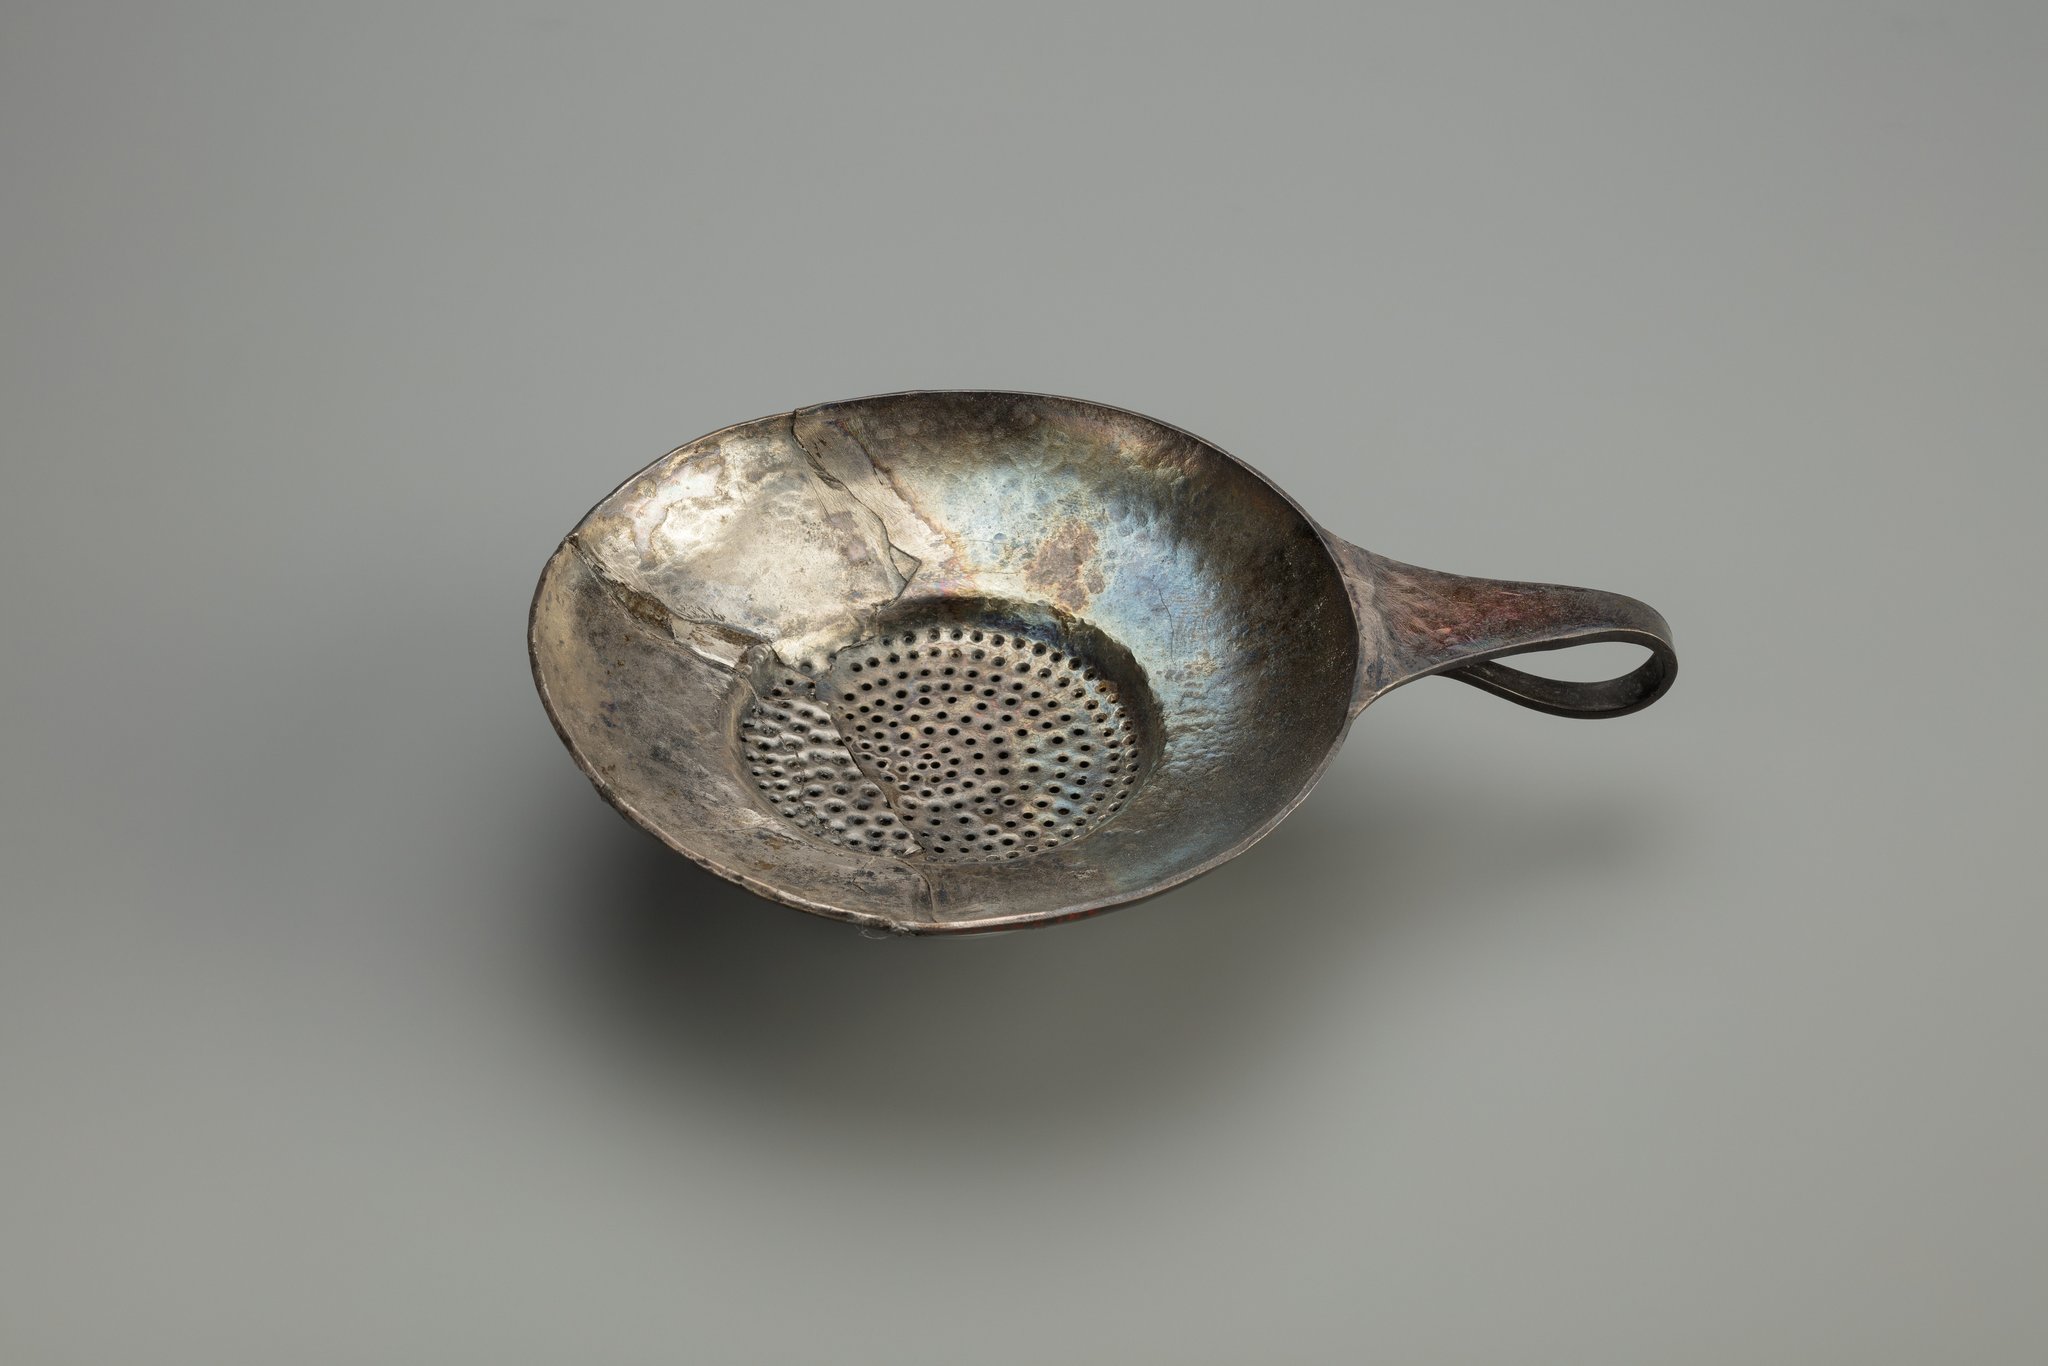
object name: strainer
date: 1279-1213 BCE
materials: silver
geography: egypt